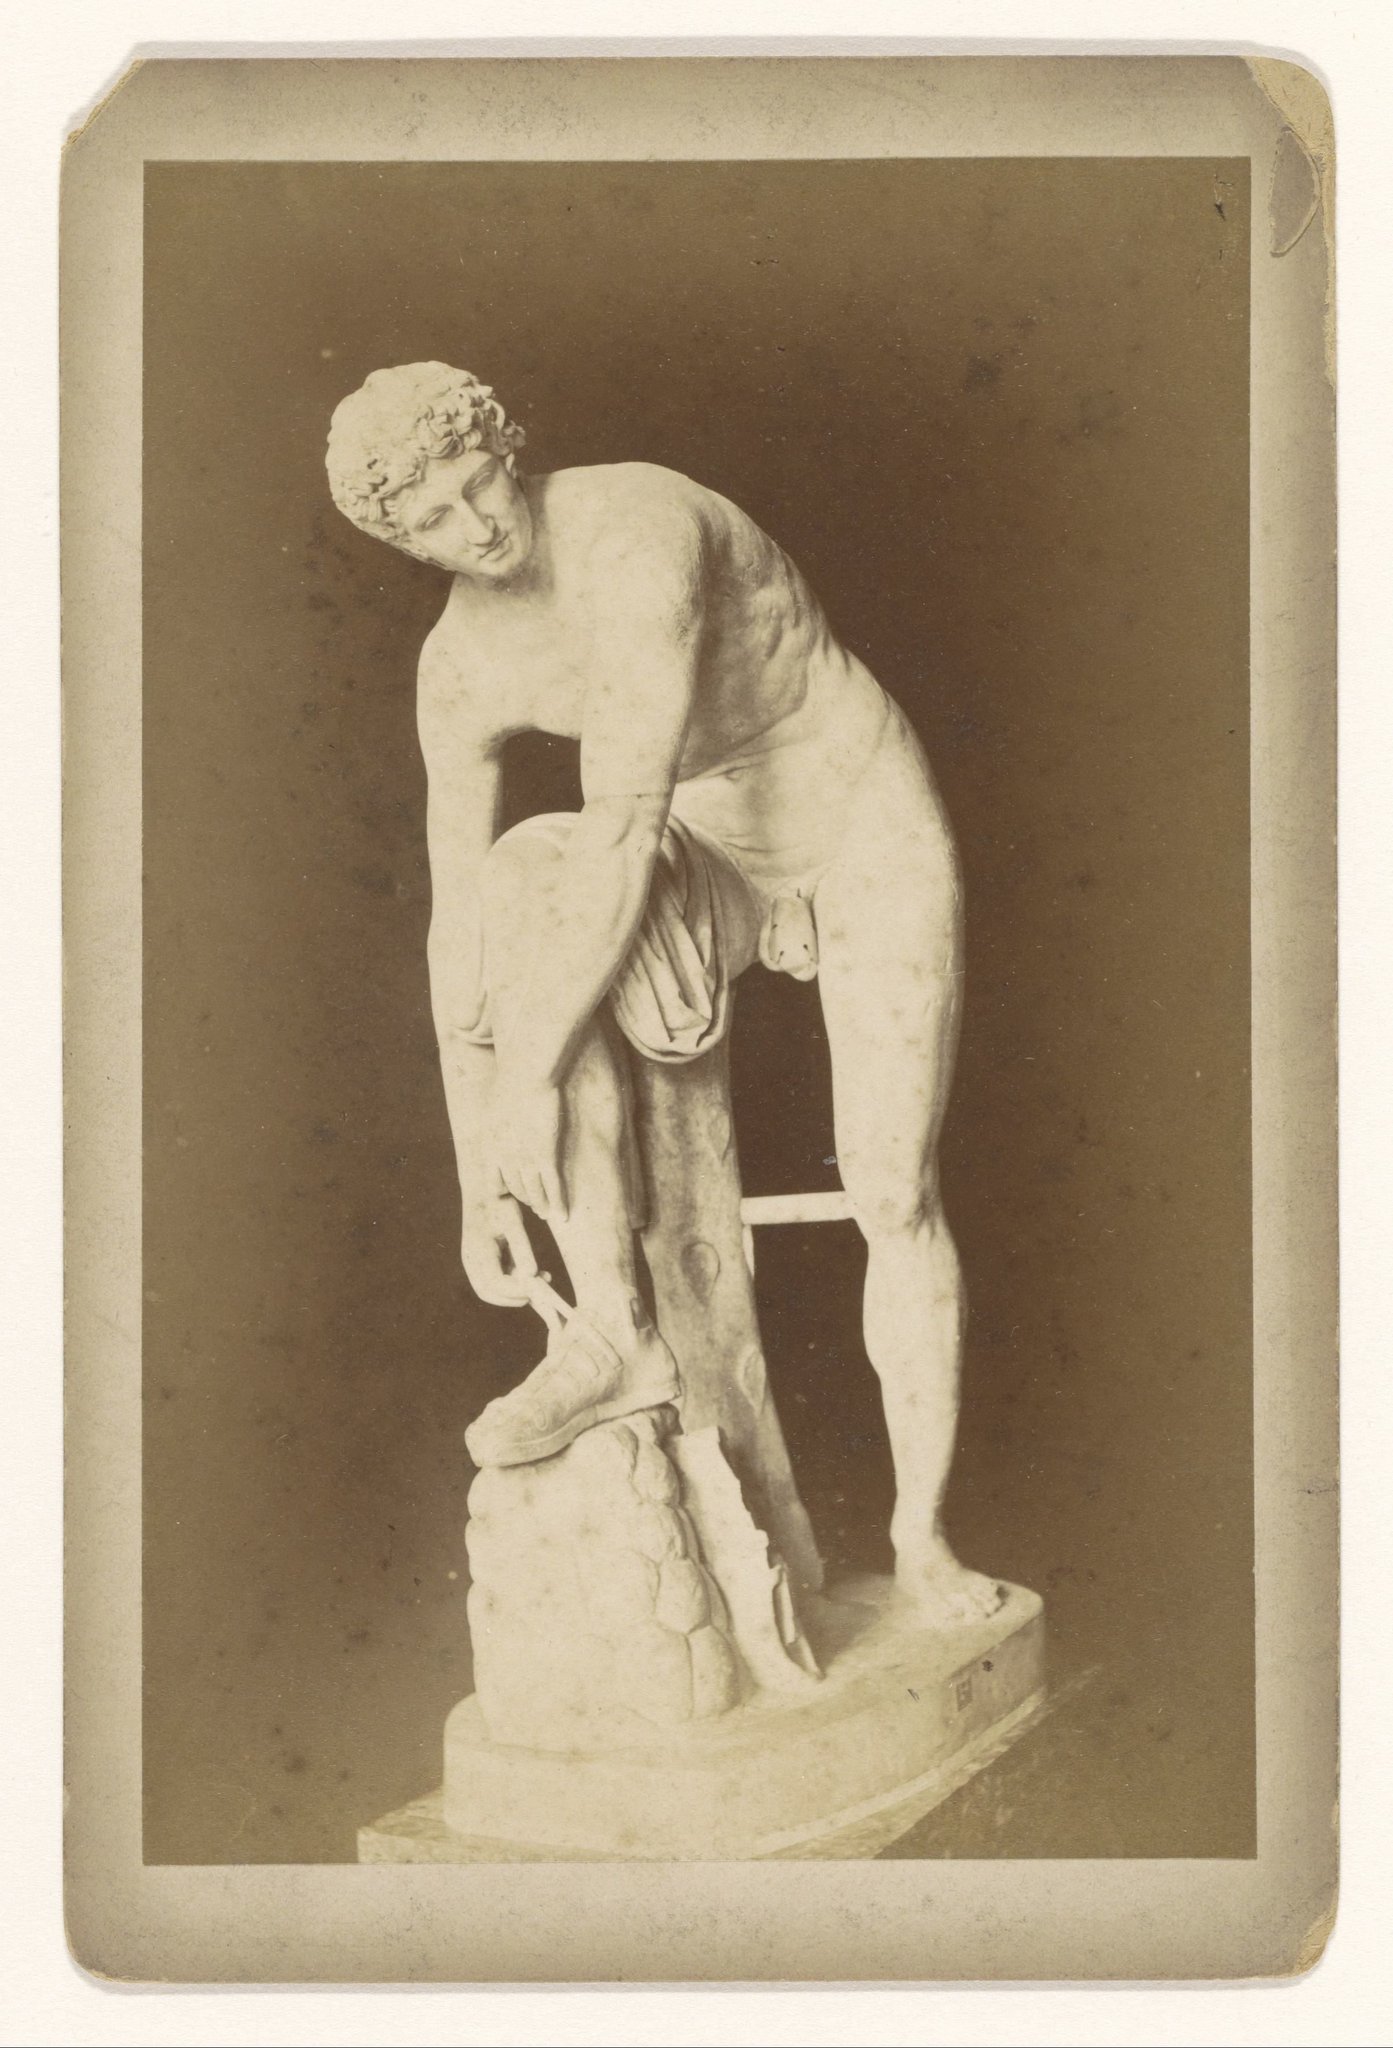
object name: photograph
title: Heroen-Saal. Statue des Mercurius.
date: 1863-1898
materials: cardboard, paper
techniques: albumen print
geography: munich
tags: (story of) mercury (hermes), piece of sculpture, reproduction of a piece of sculpture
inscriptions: collector's mark: ‘Vosmaer’, number: ‘3.’